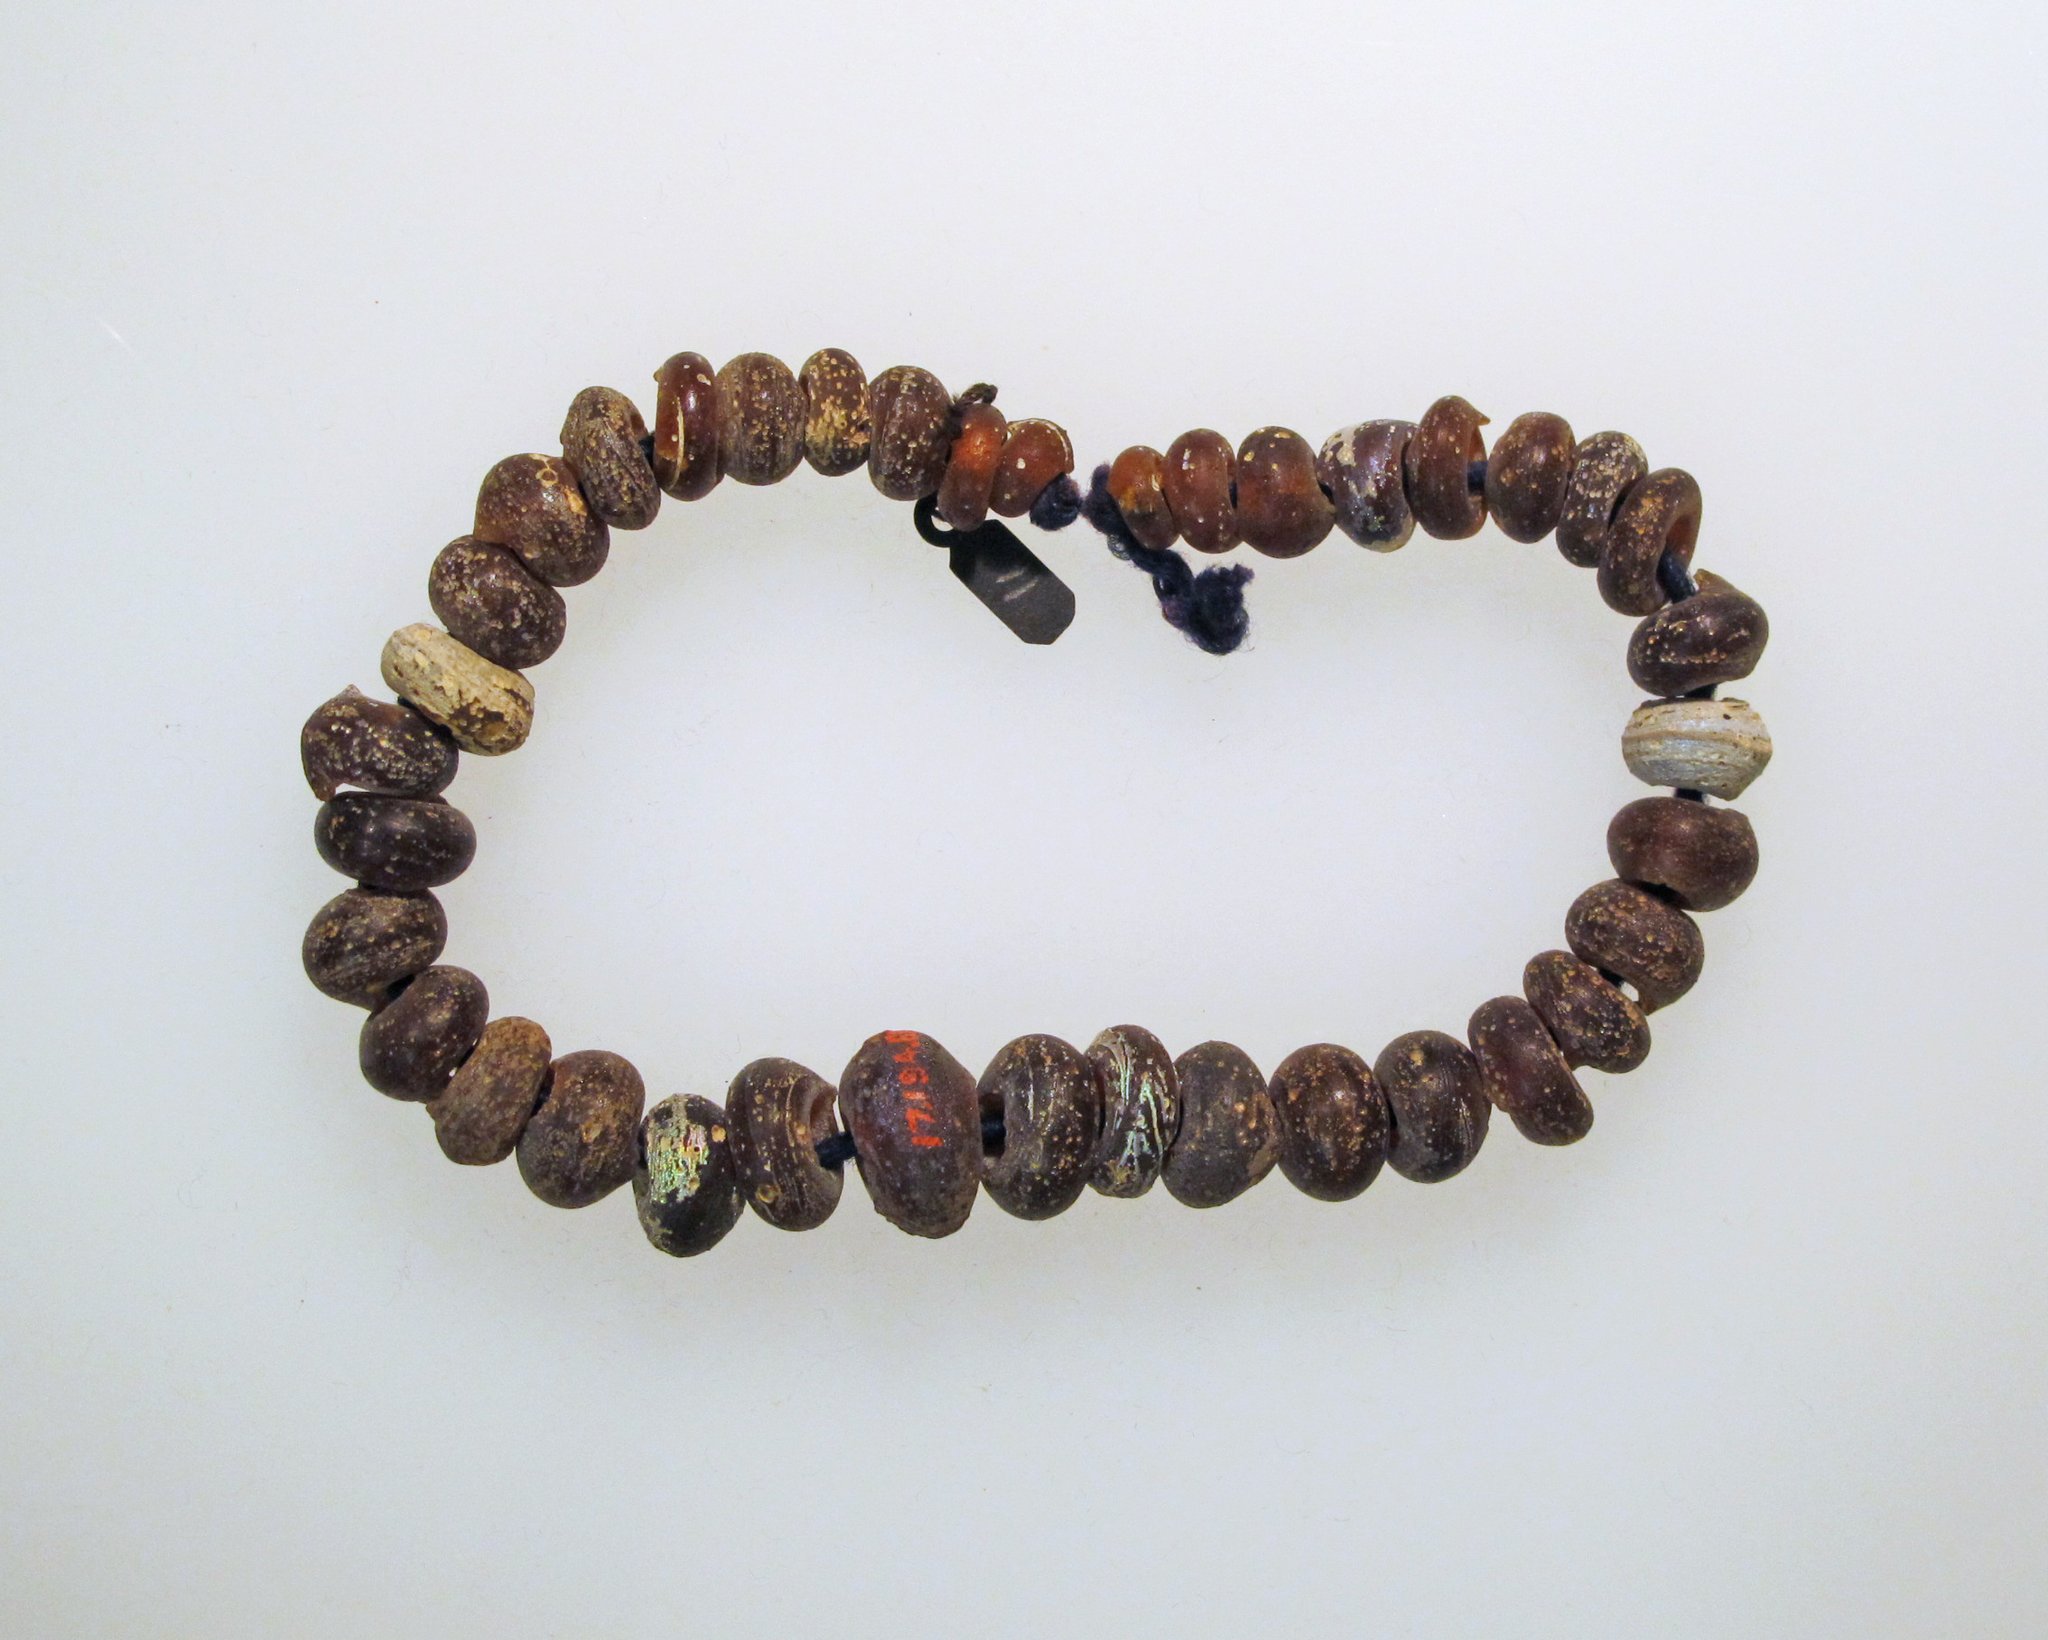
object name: bead, 38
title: Beads, 38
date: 7000 BCE-330 CE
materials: glass